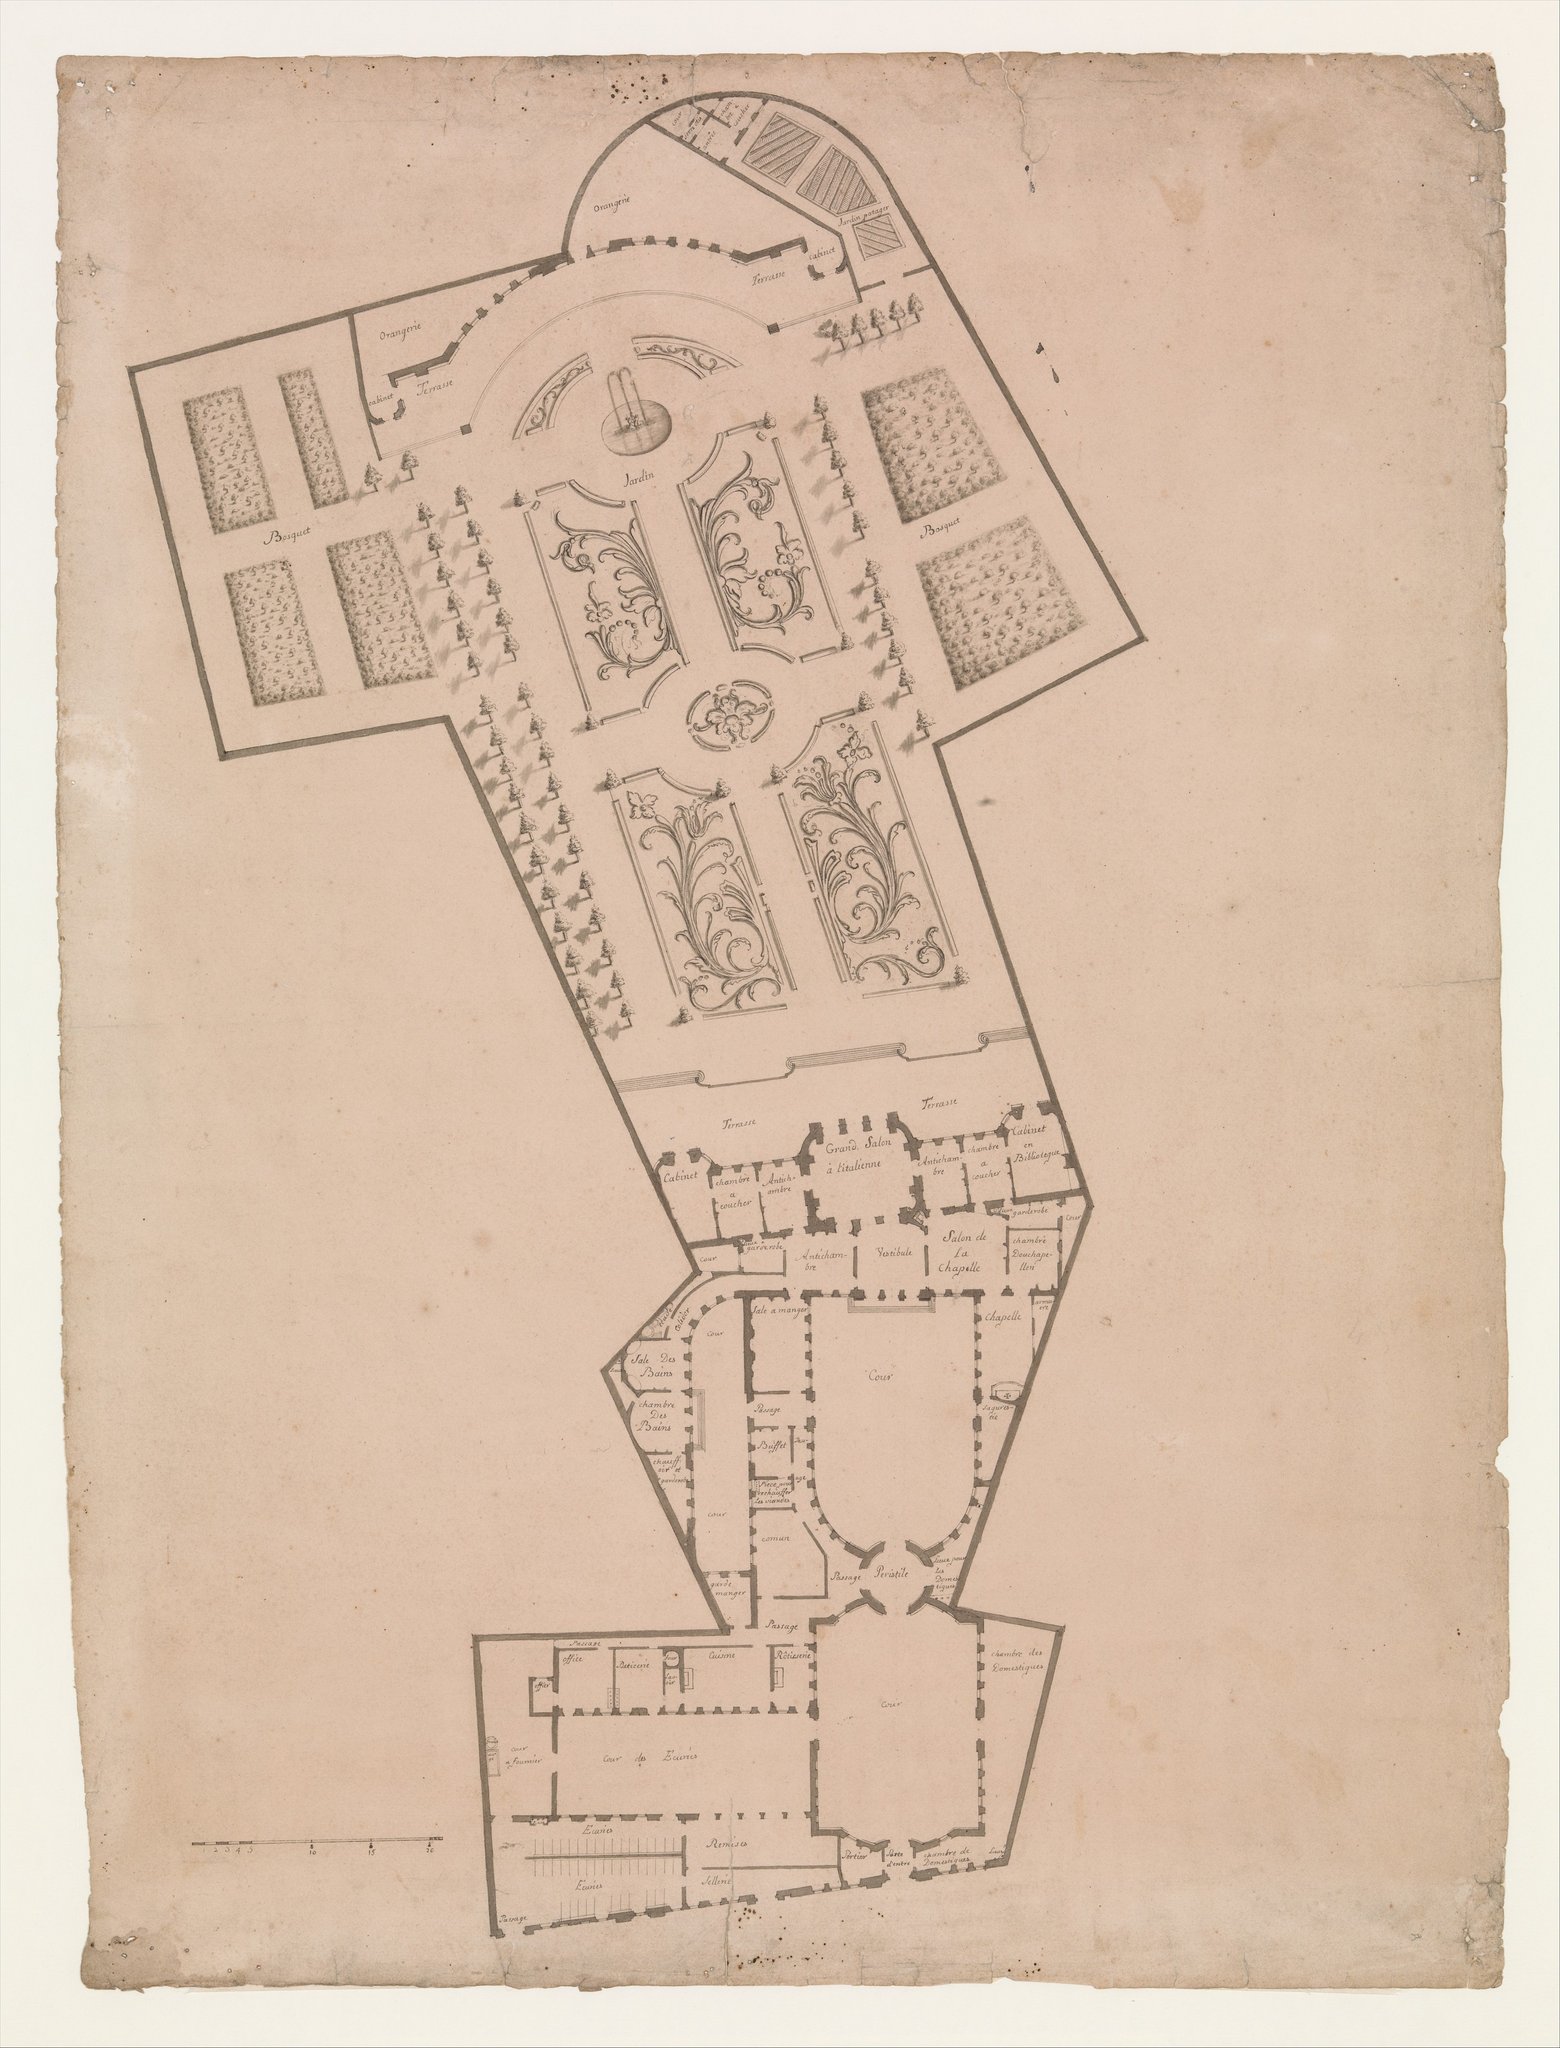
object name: drawing ornament architecture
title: Plan of a Hotel and Garden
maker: anonymous, french, 17th century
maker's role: artist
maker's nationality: french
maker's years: 1600-1700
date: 1667-1733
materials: ink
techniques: brush, pen, wash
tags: architecture,gardens